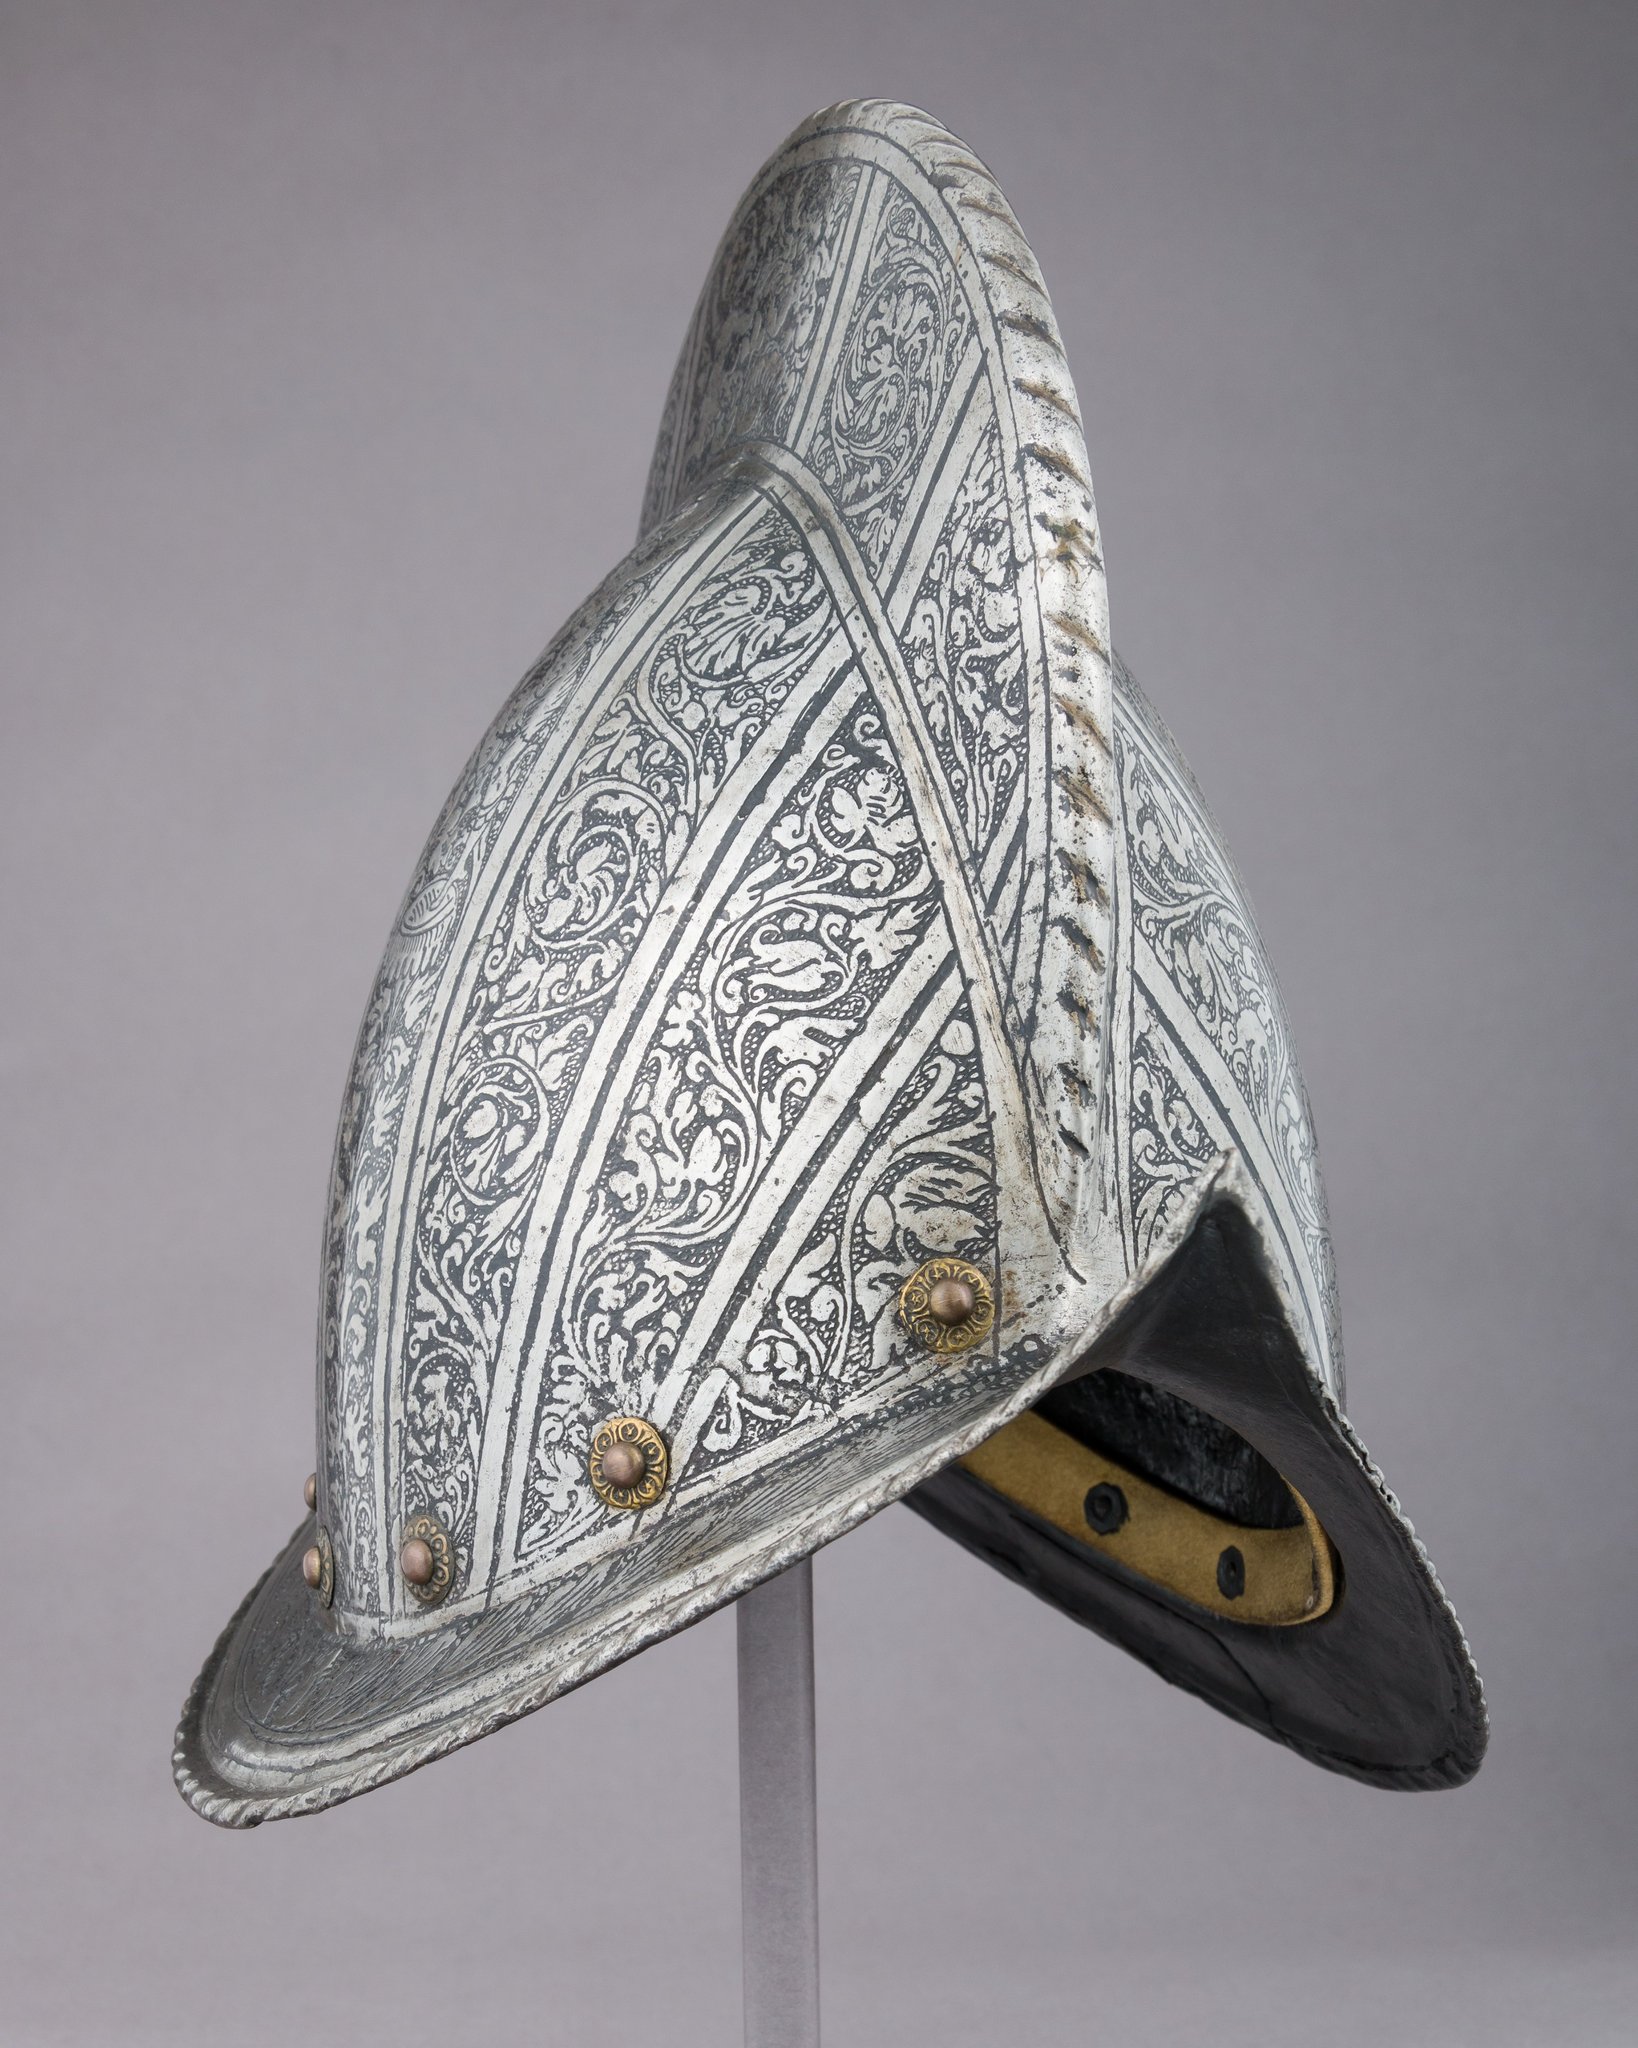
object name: morion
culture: italian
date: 1575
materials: brass, leather, steel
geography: italy